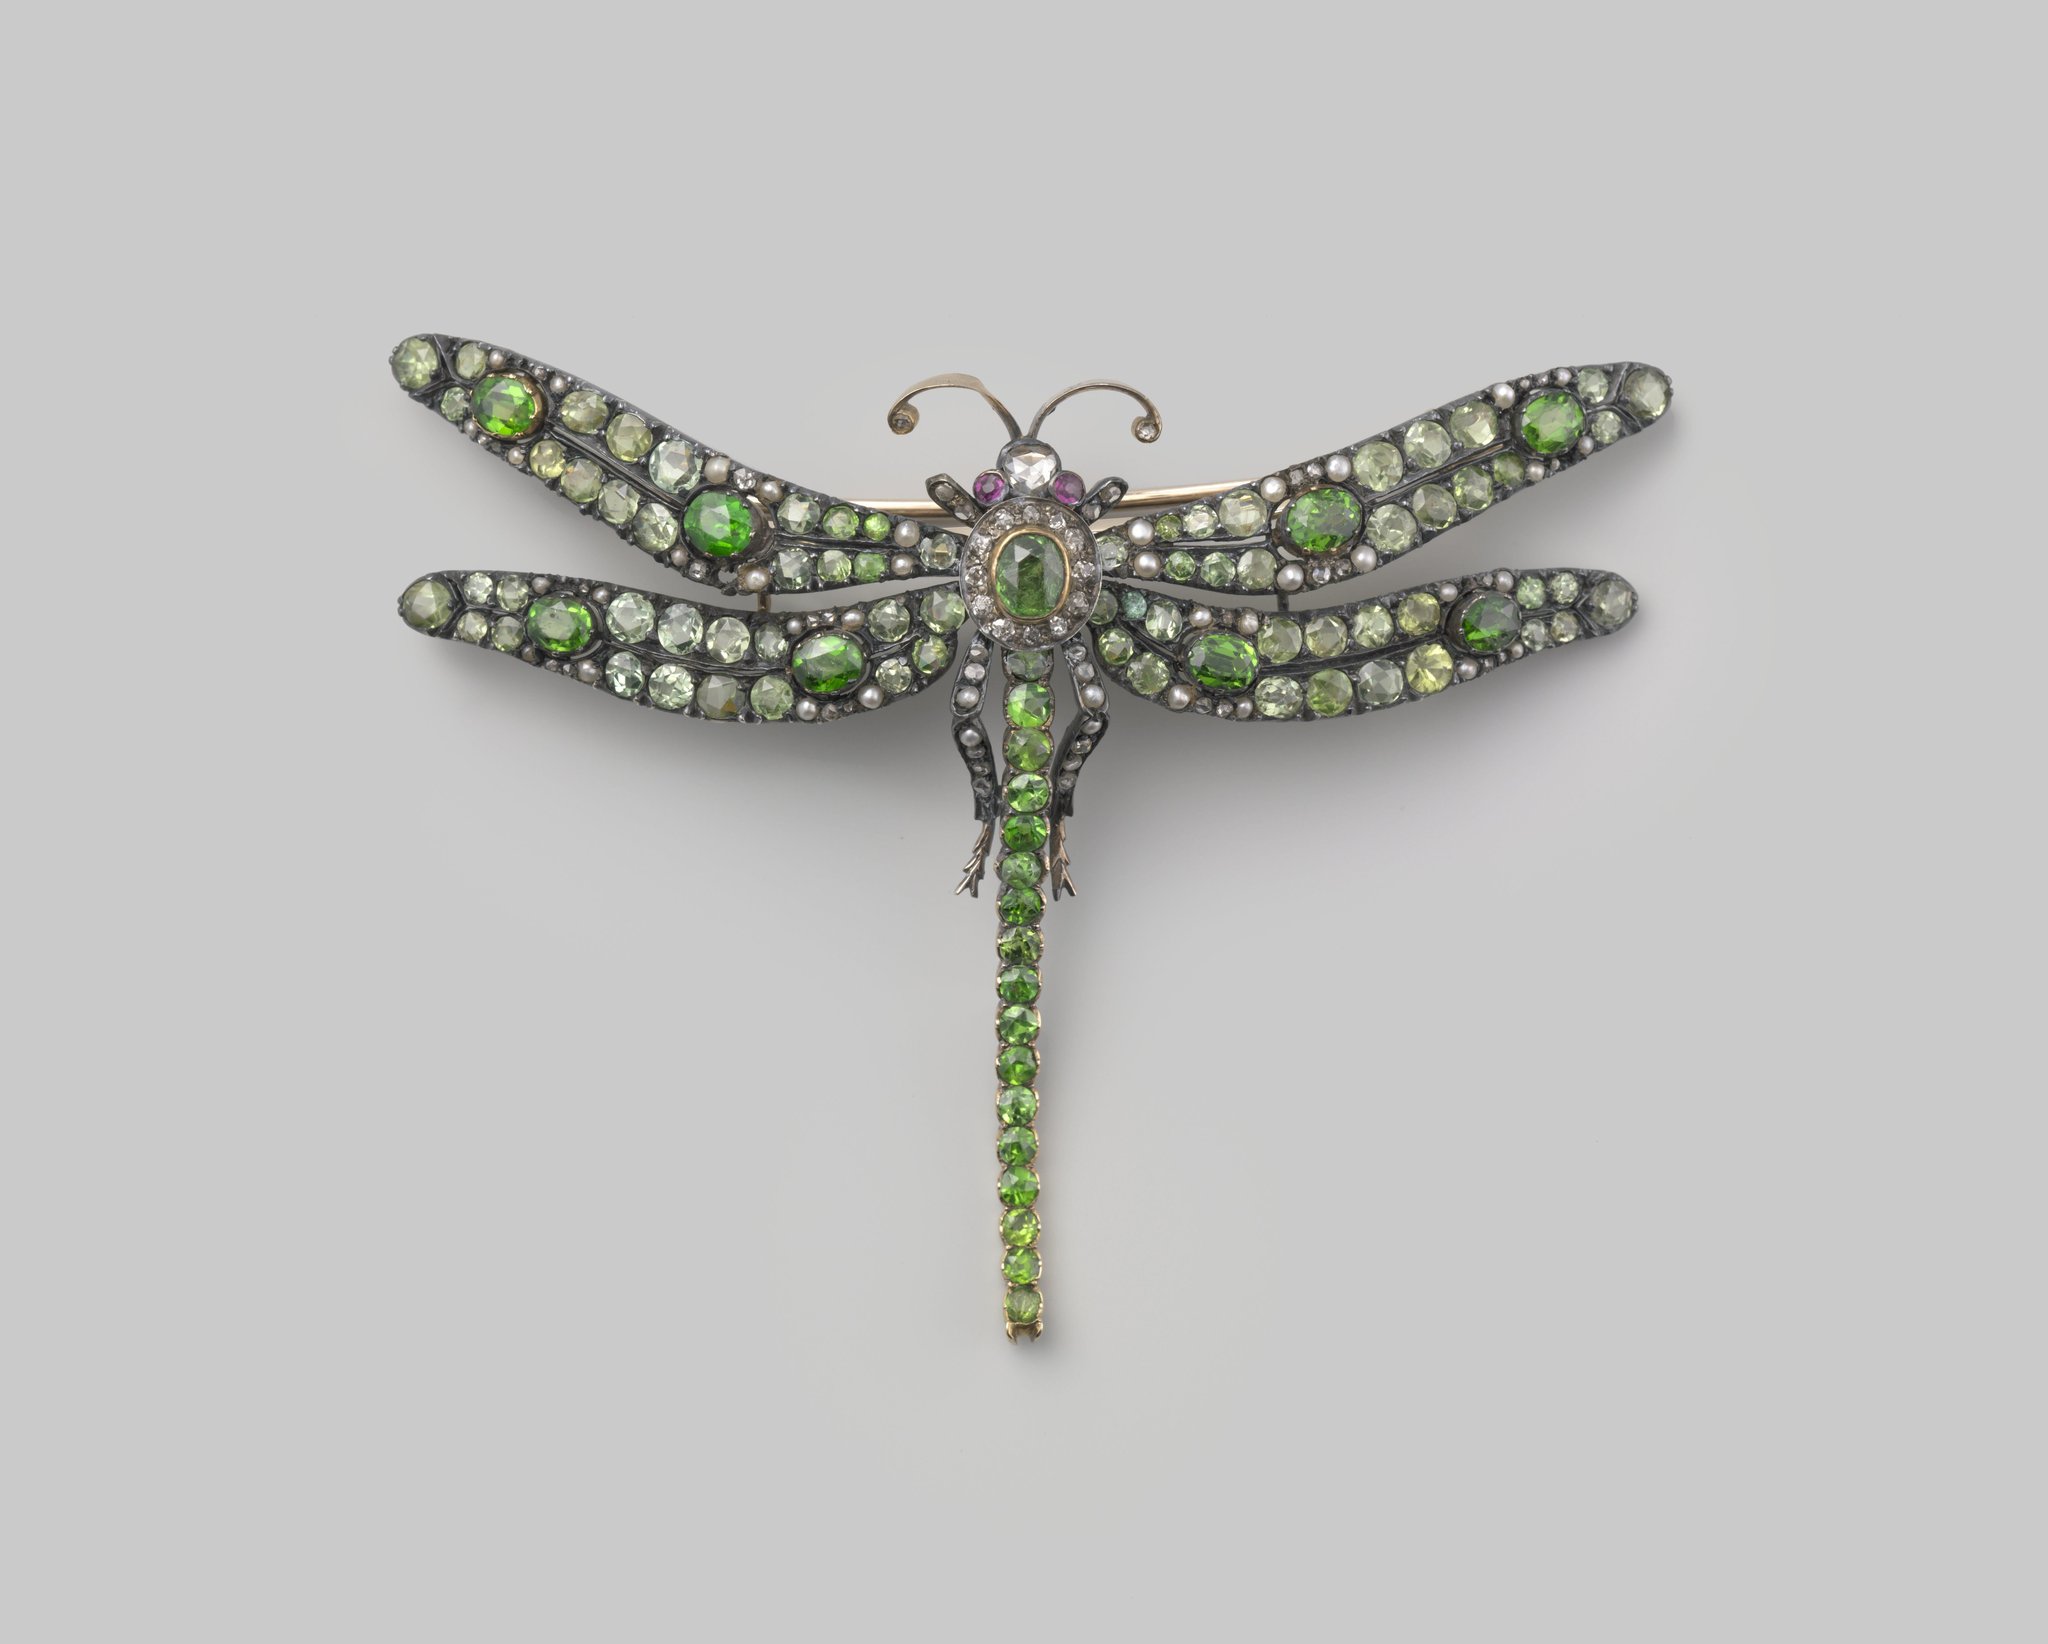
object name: jewellery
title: Broche in de vorm van een libelle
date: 1890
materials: diamond, gemstone, gold, pearl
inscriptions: mark: ‘ster in cirkel’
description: Broche van goud, diamanten, robijnen, demantoiet (groene granaat) en parels, in de vorm van een libelle.